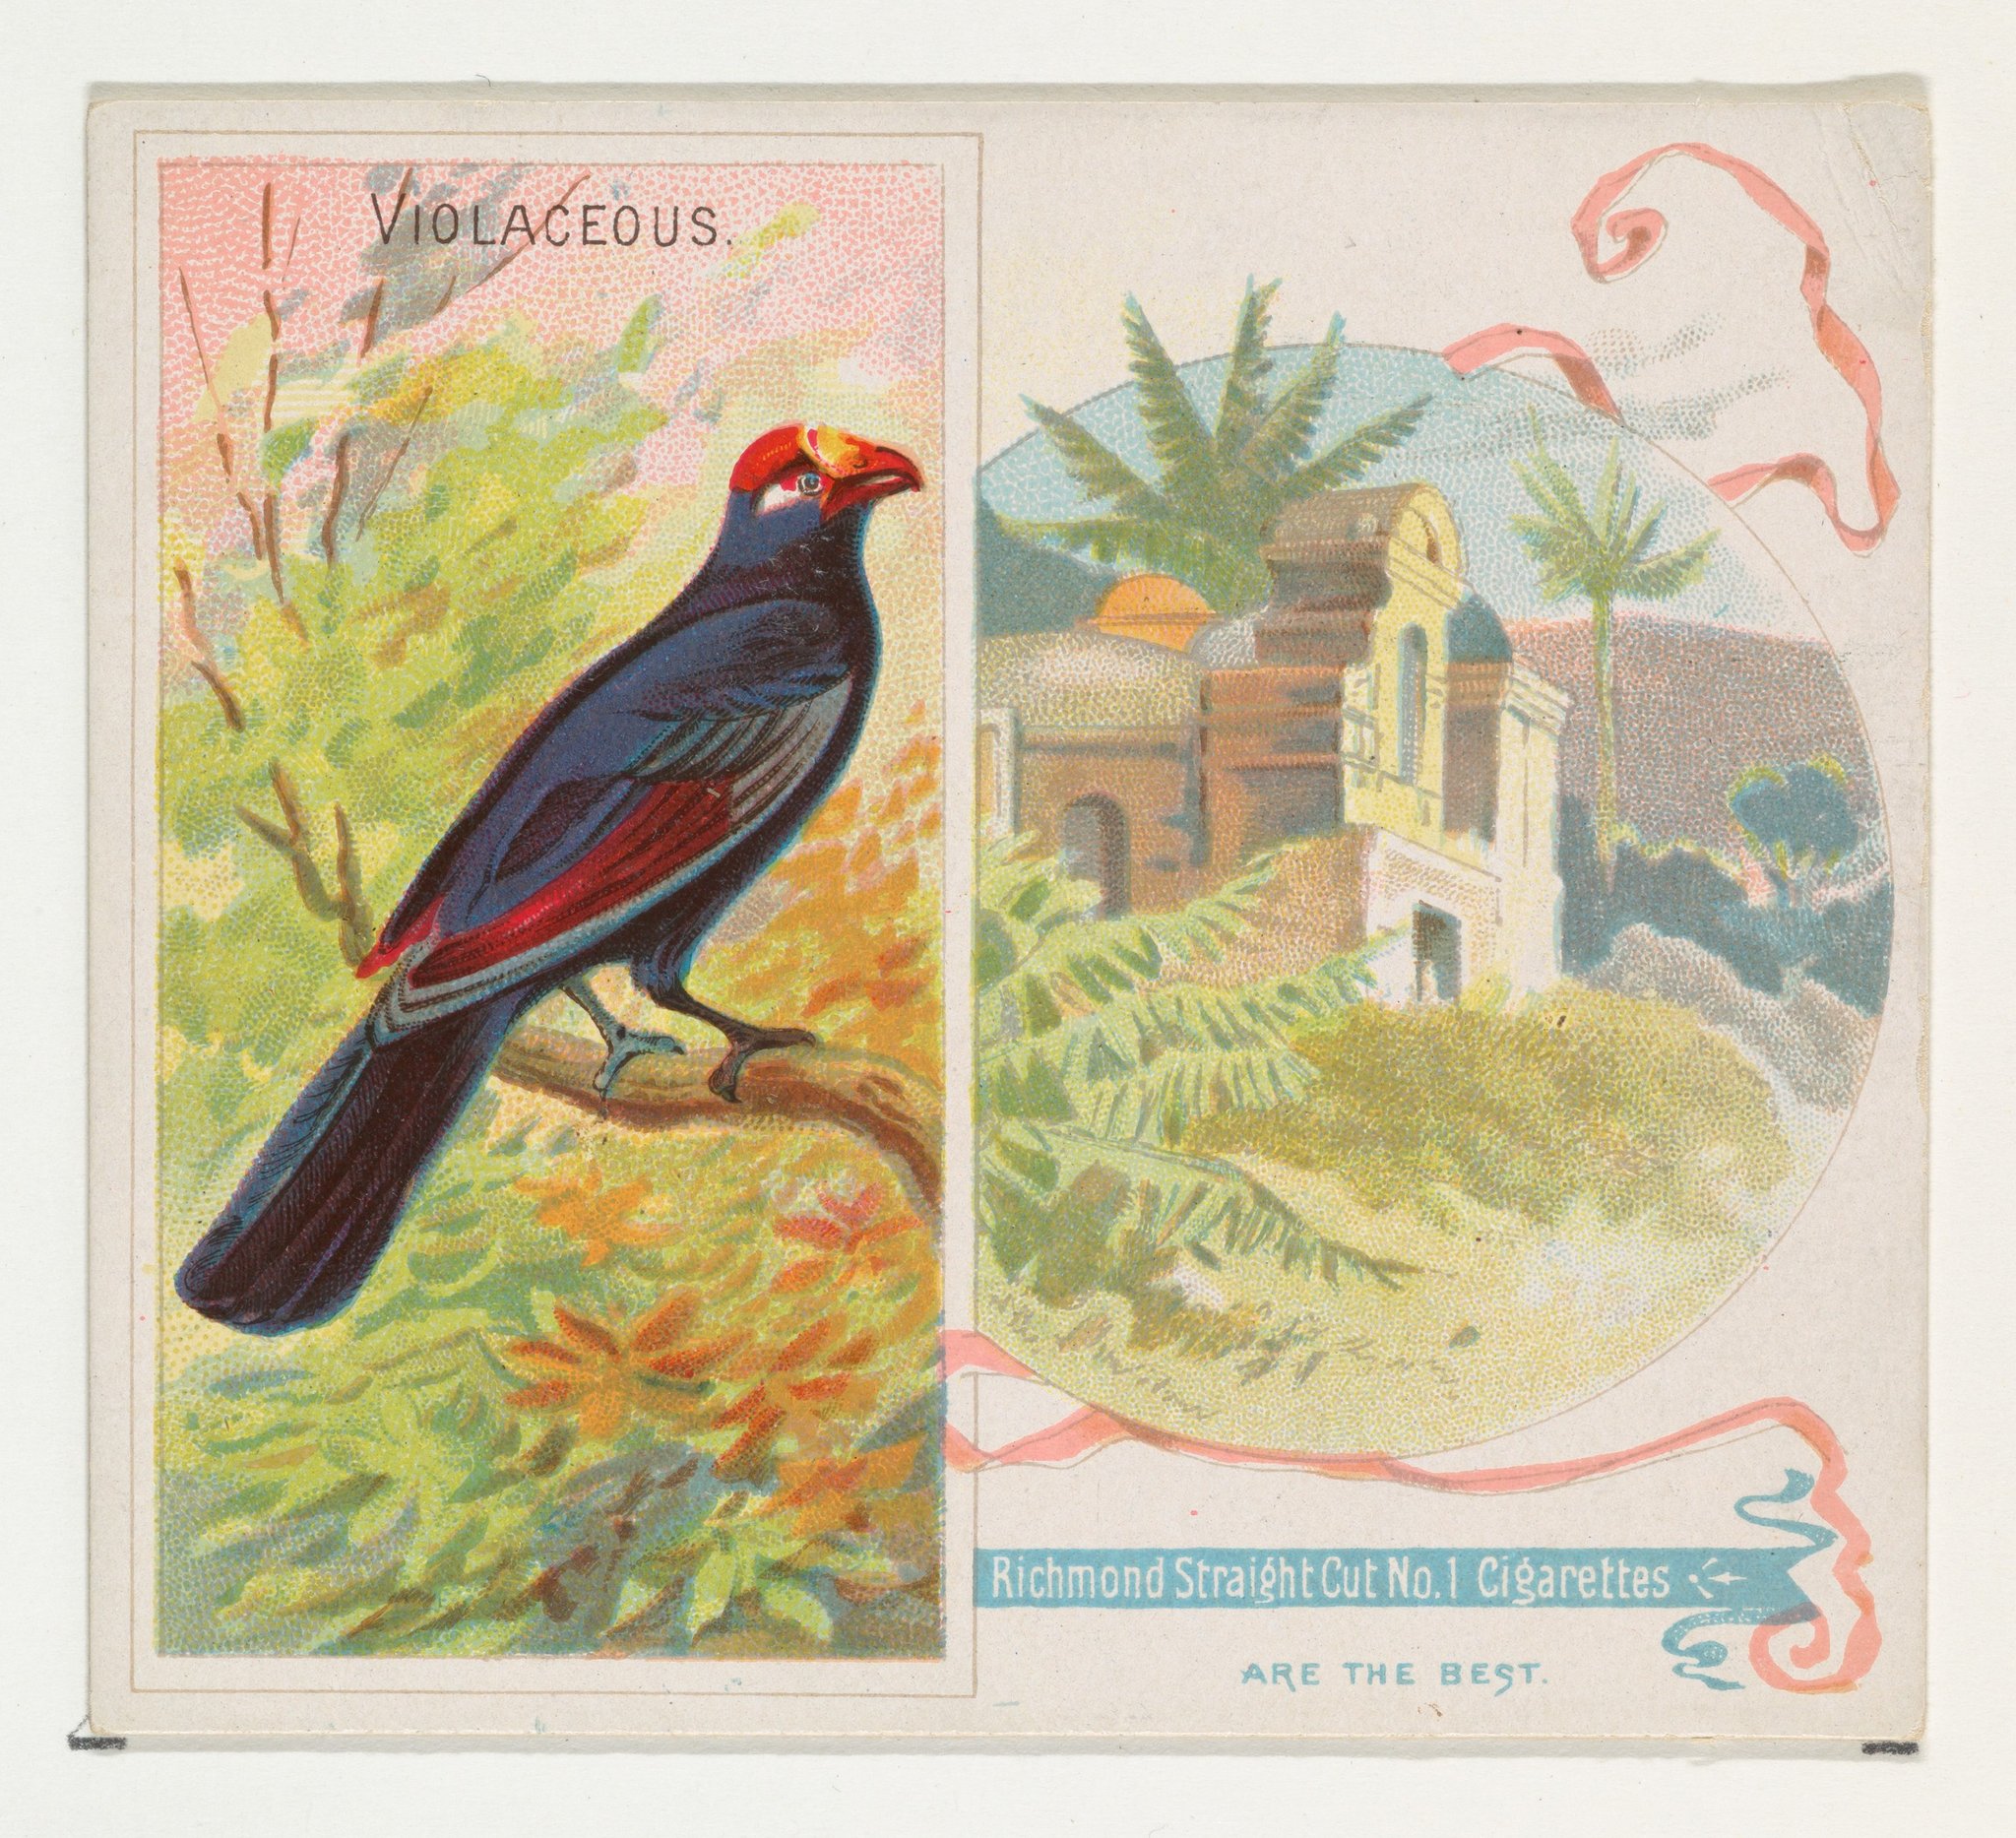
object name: print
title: Violaceous, from Birds of the Tropics series (N38) for Allen & Ginter Cigarettes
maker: allen & ginter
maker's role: publisher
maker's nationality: american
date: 1889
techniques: color lithograph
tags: birds